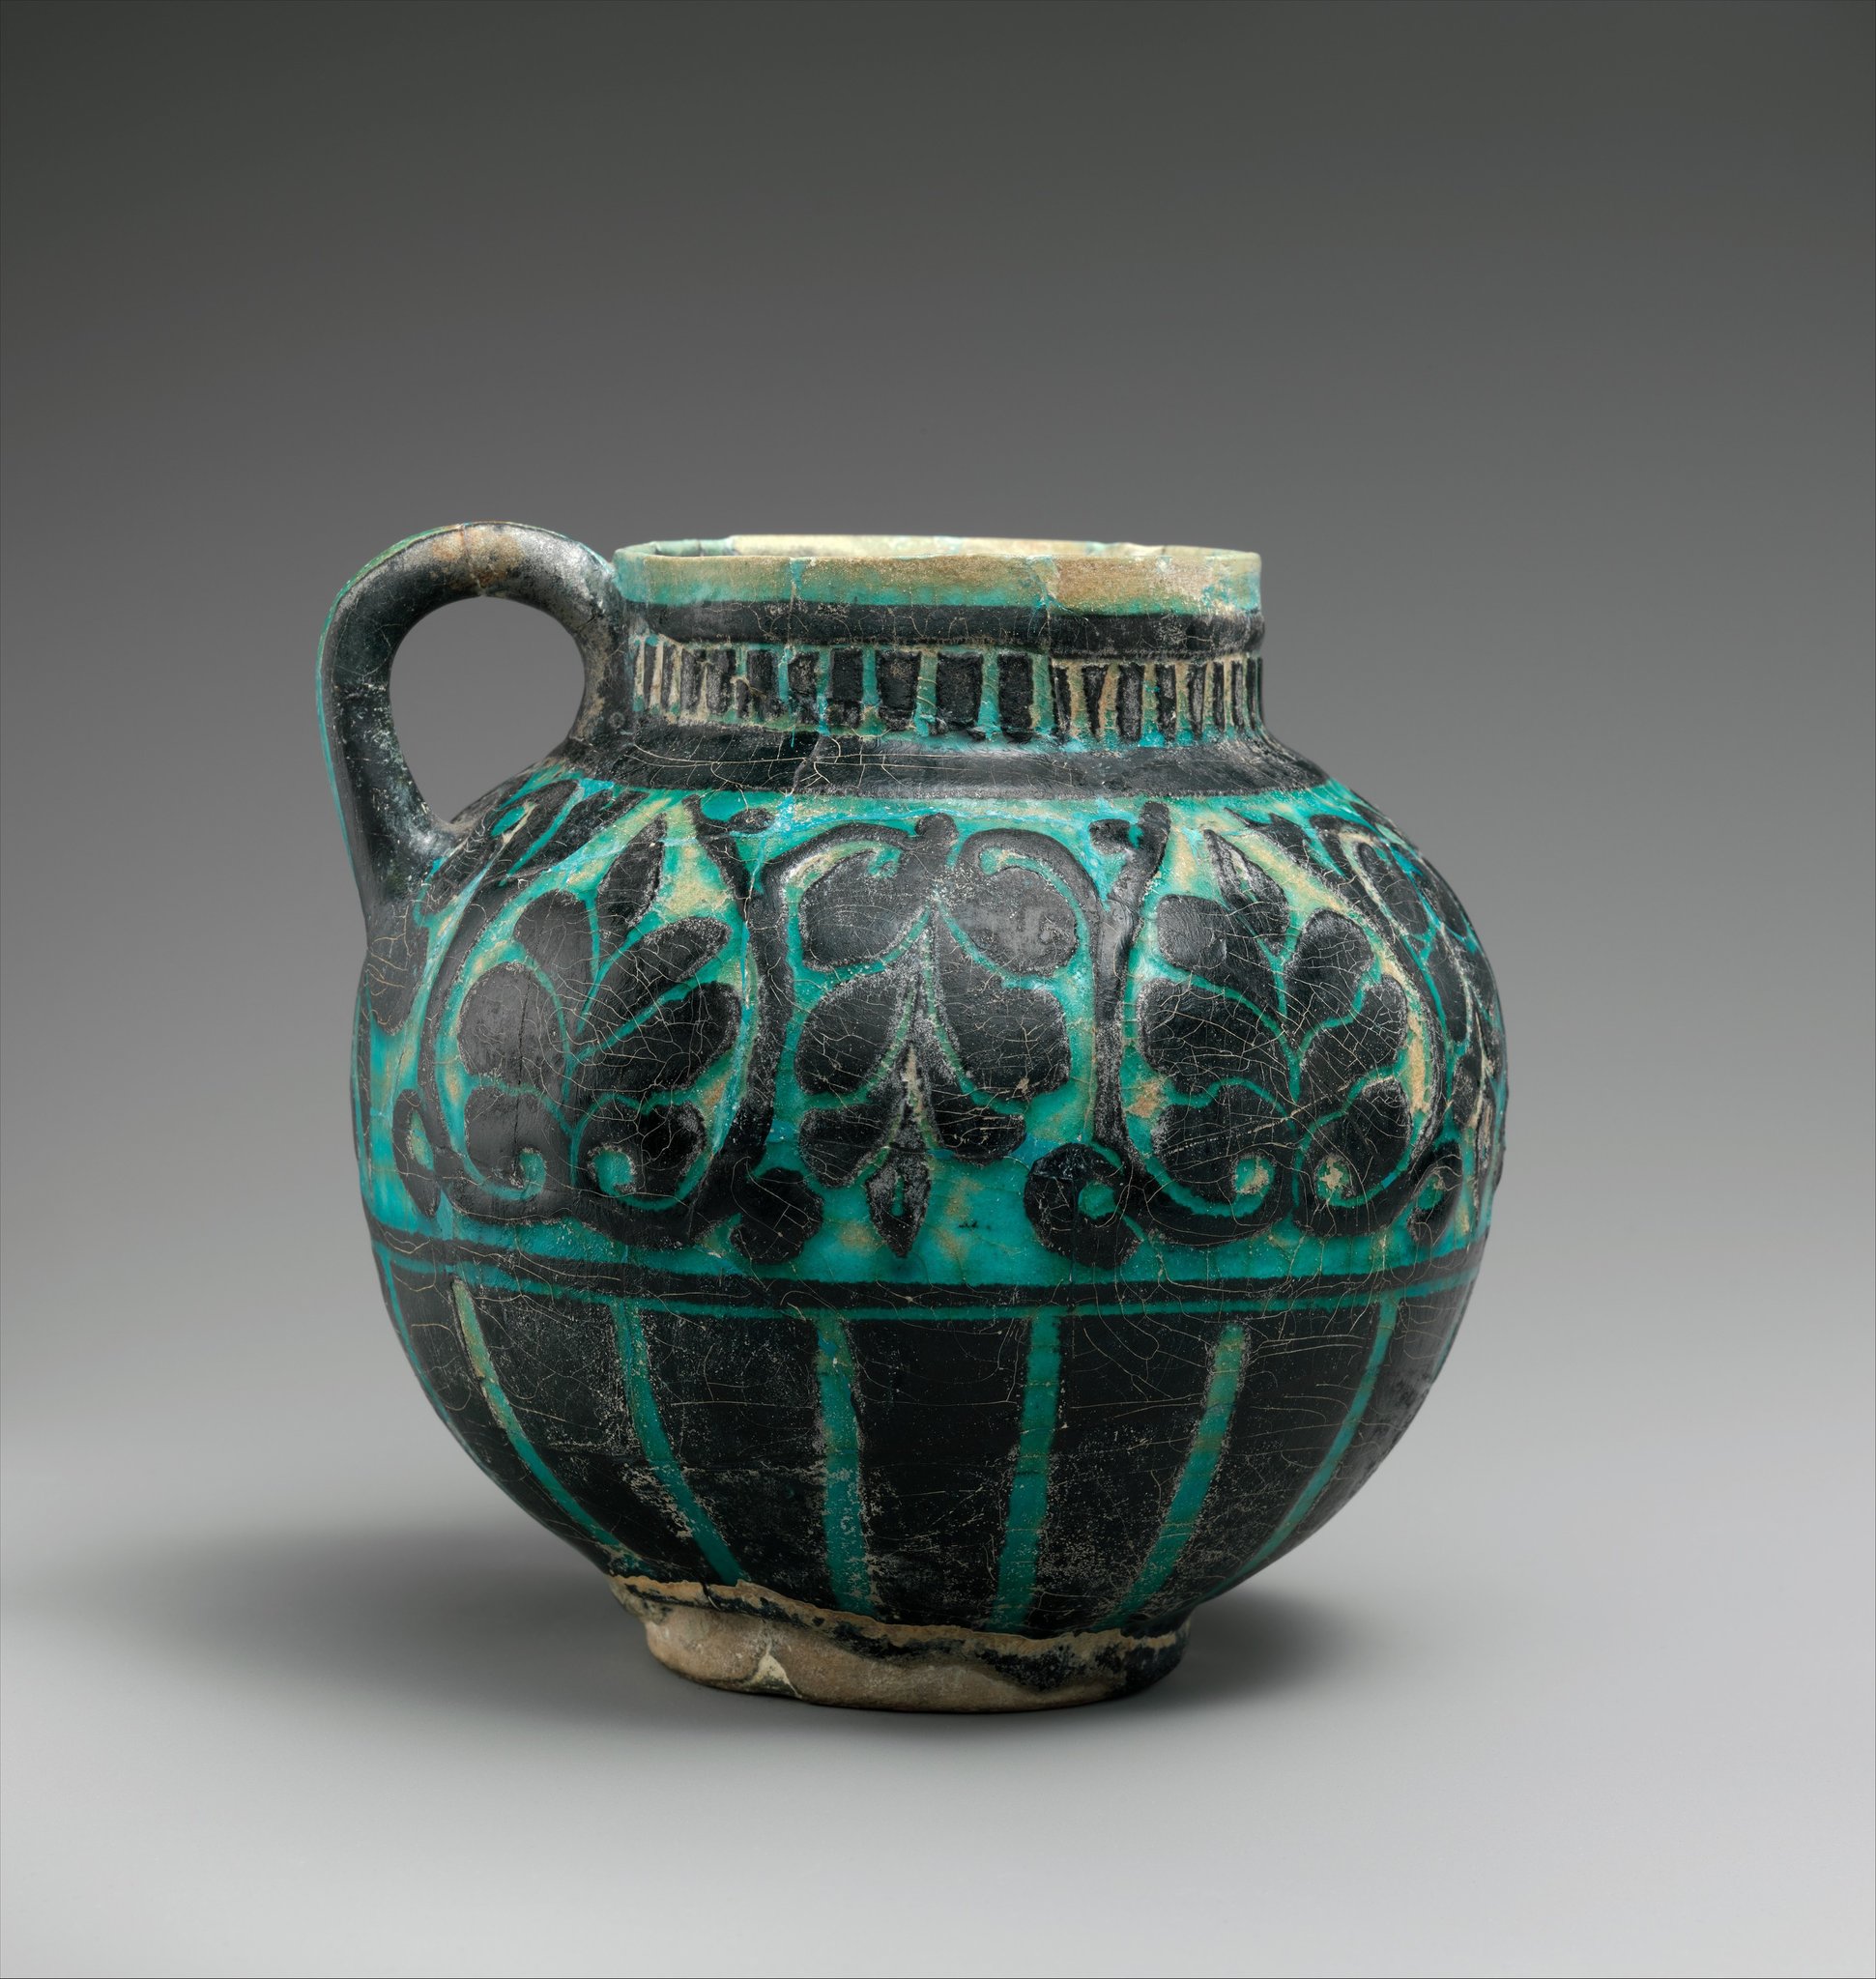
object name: jug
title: Jug with Floral Decoration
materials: stonepaste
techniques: painting, underglaze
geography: iran